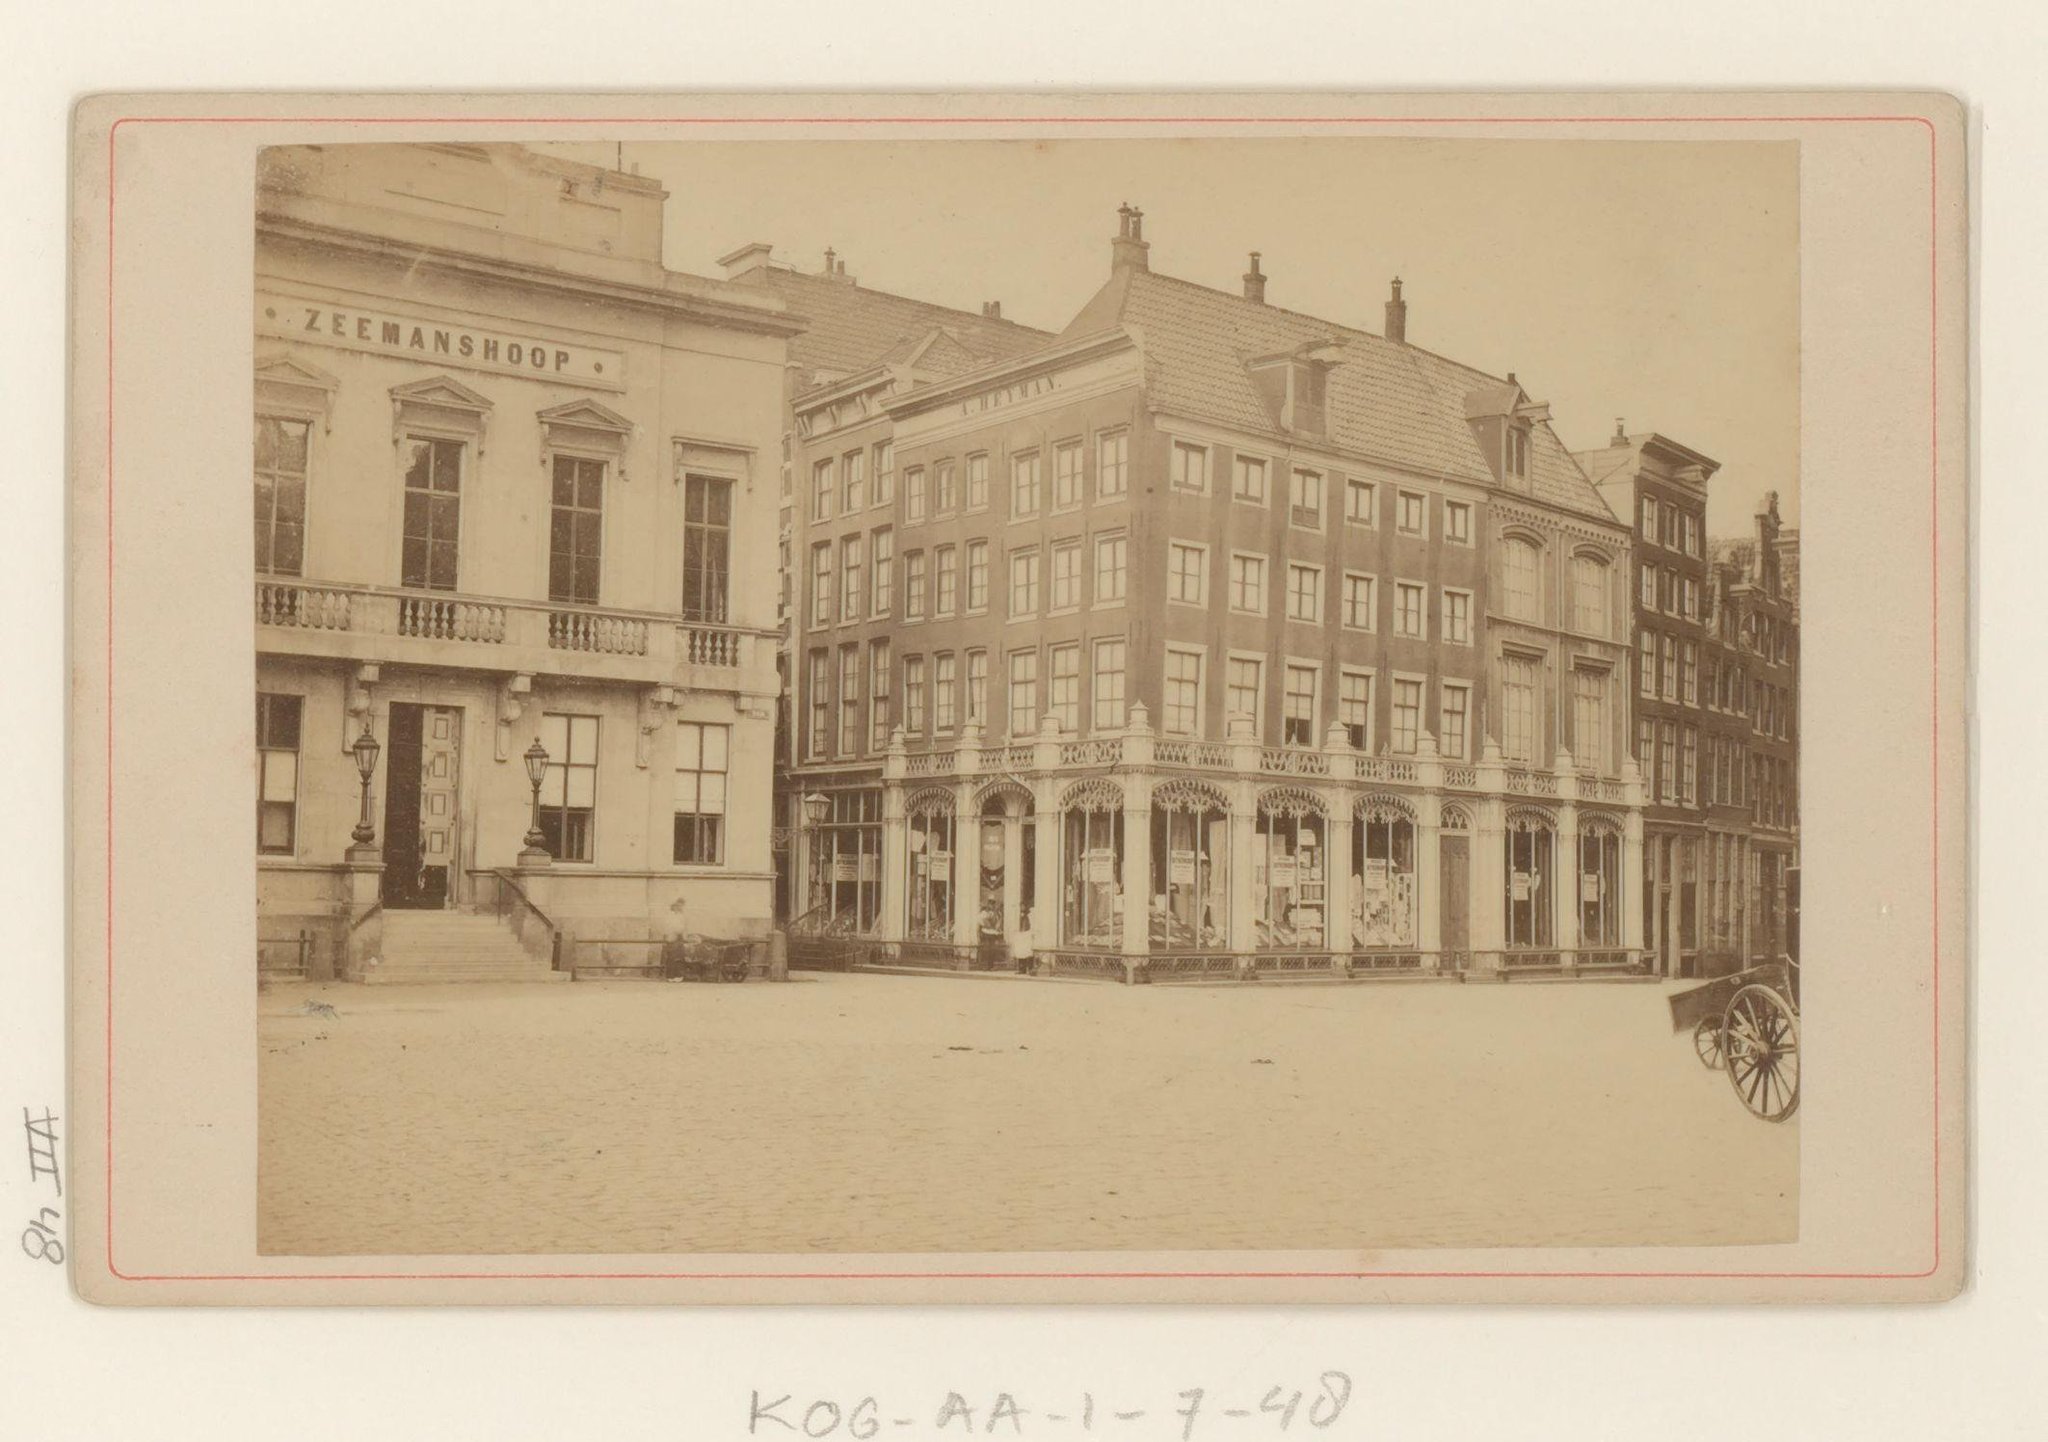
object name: photograph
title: Gezicht op de Dam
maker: Anonymous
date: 1860-1900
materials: cardboard, paper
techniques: albumen print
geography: amsterdam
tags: square, place, circus, etc., city-view in general; 'veduta', façade (of house or building)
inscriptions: collector's mark: ‘7’ Lugt 1641b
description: Onderwerpsrubriek binnen de Atlas Amsterdam: Dam (na 1835).